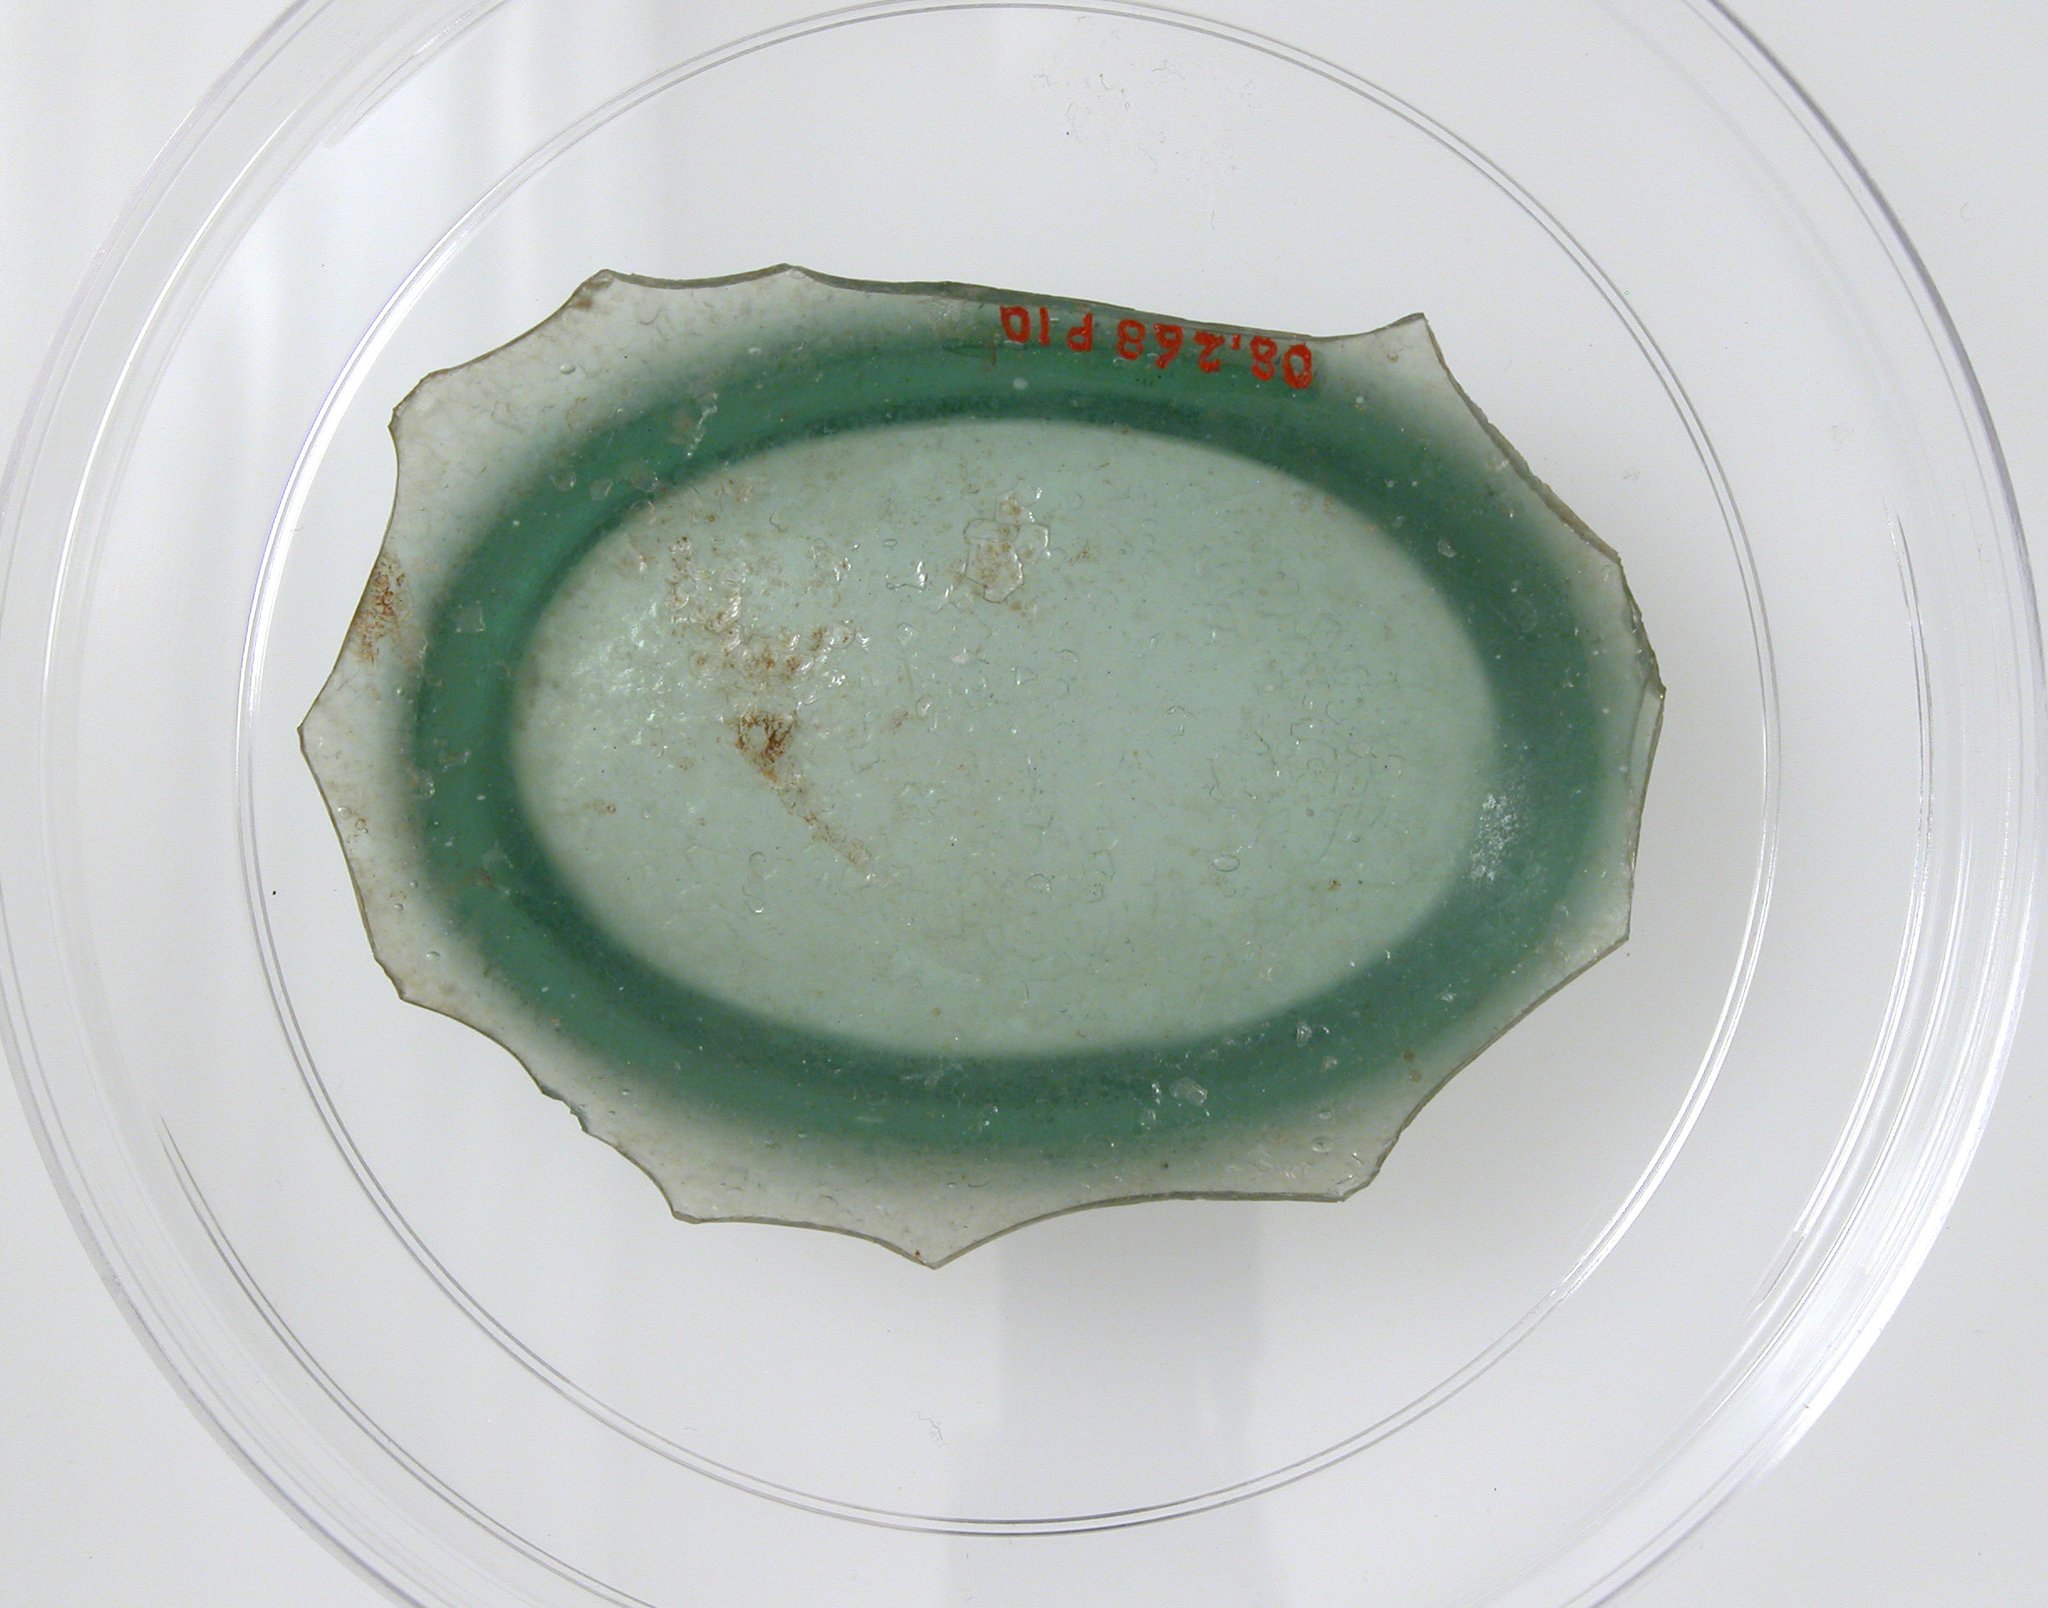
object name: fragment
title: Bottom and Foot of a Vessel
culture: coptic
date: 301-433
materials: glass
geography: egypt